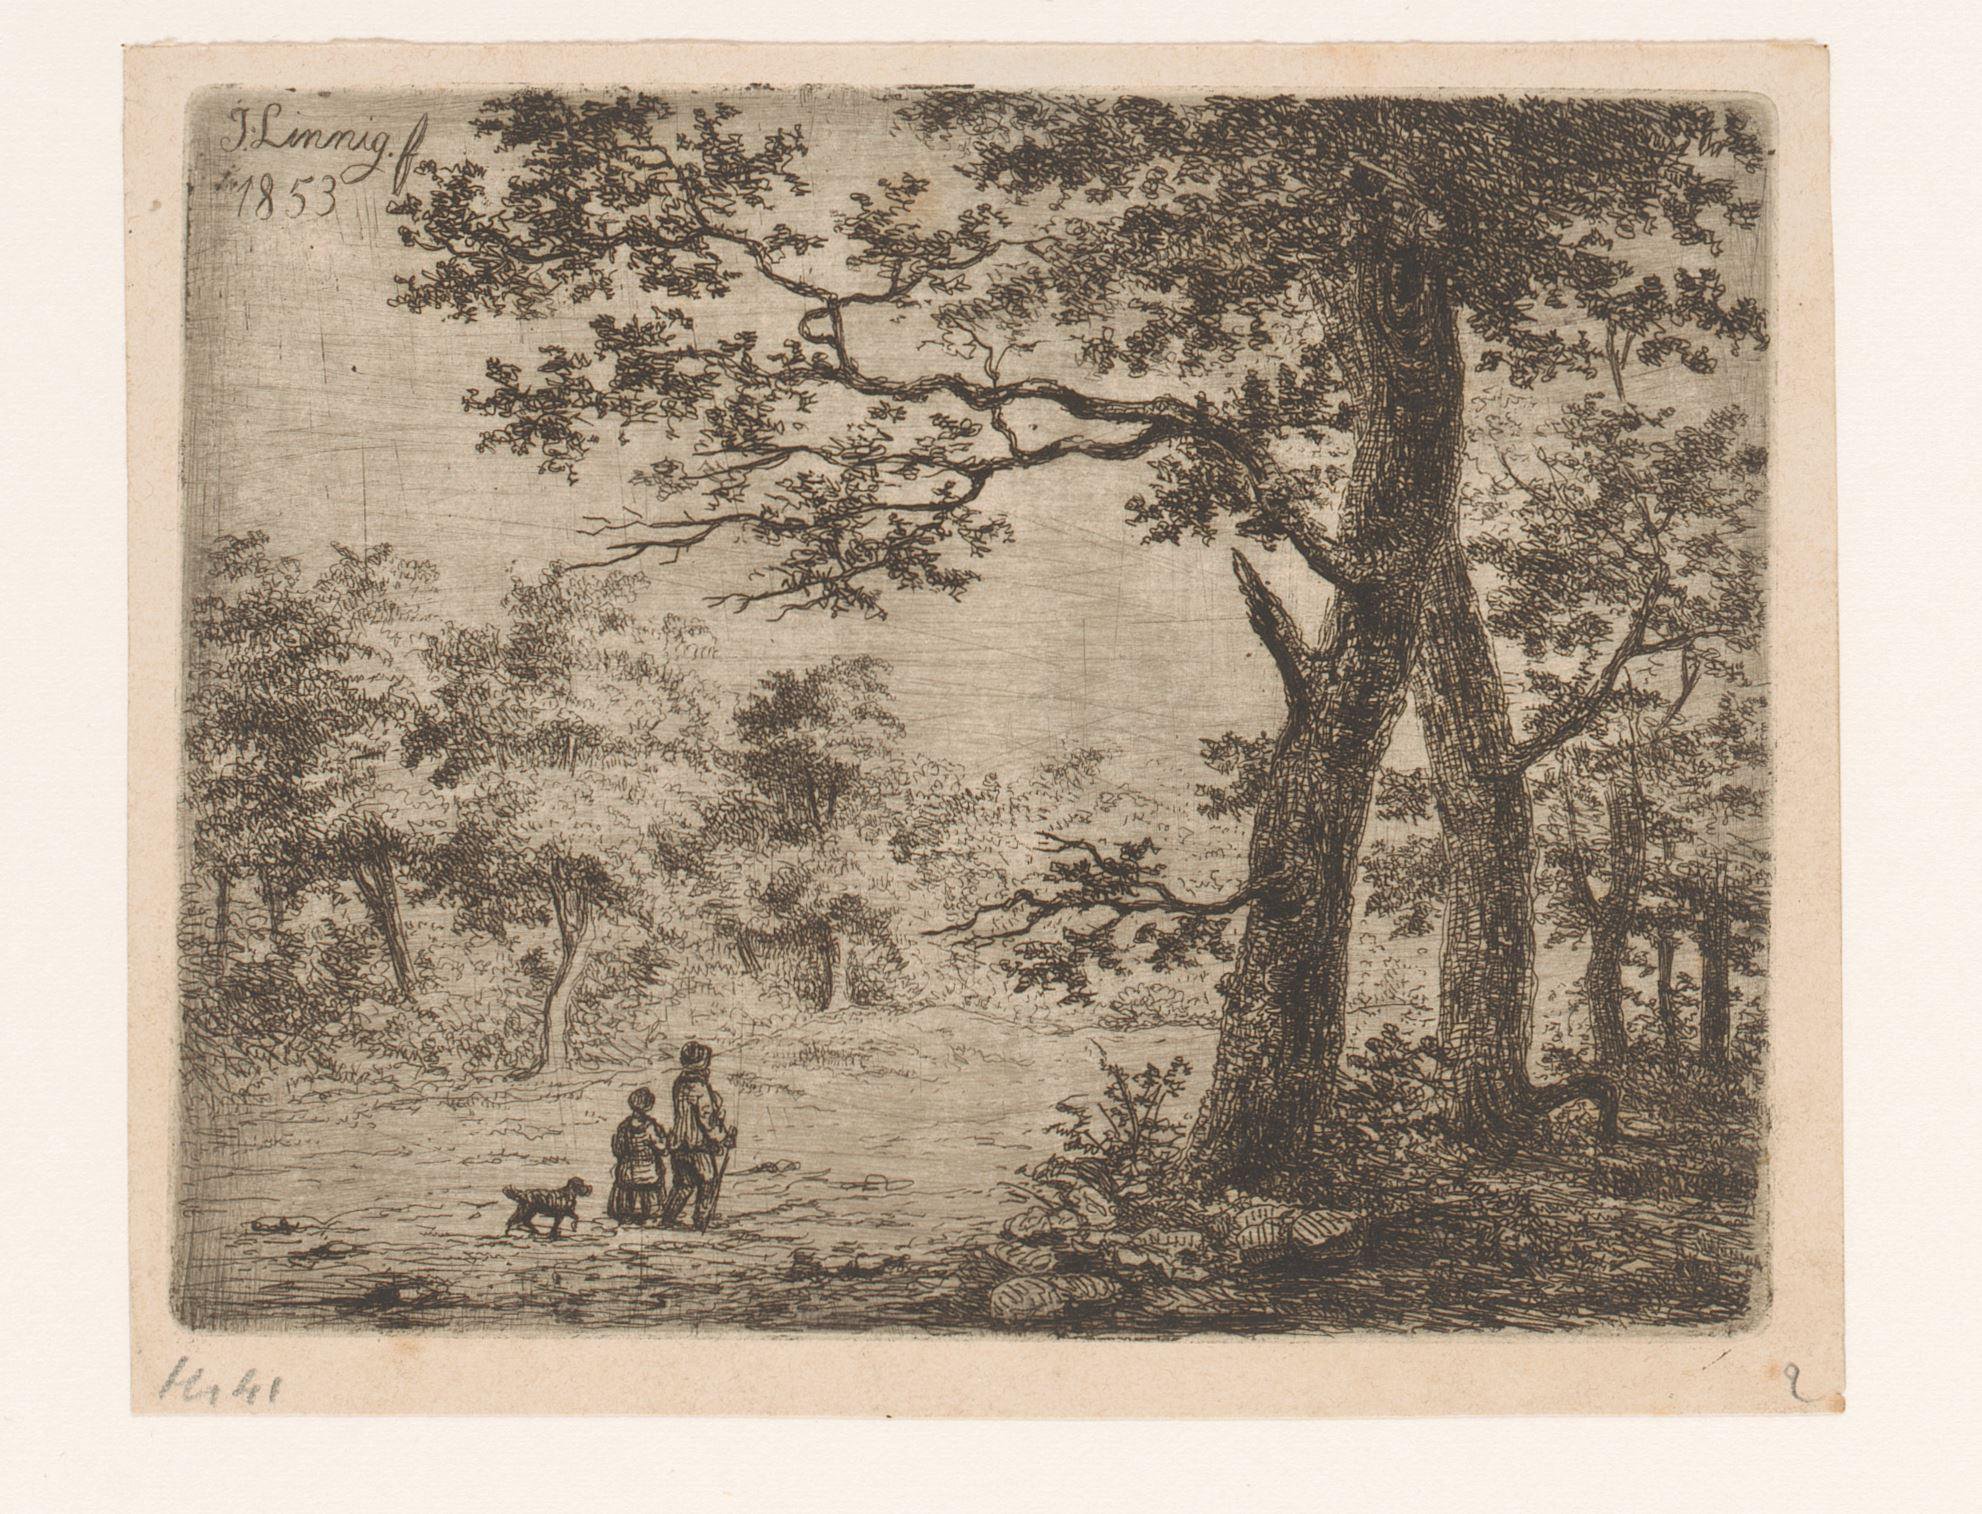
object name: print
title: Twee wandelaars met een hond in het bos bij Schoten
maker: jean théodore joseph linnig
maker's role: draughtsman, print maker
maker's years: 1815-1891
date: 1853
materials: paper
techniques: etching, intaglio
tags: forest path or lane (+ landscape with figures, staffage)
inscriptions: collector's mark: Lugt 1485, collector's mark: Lugt 2228